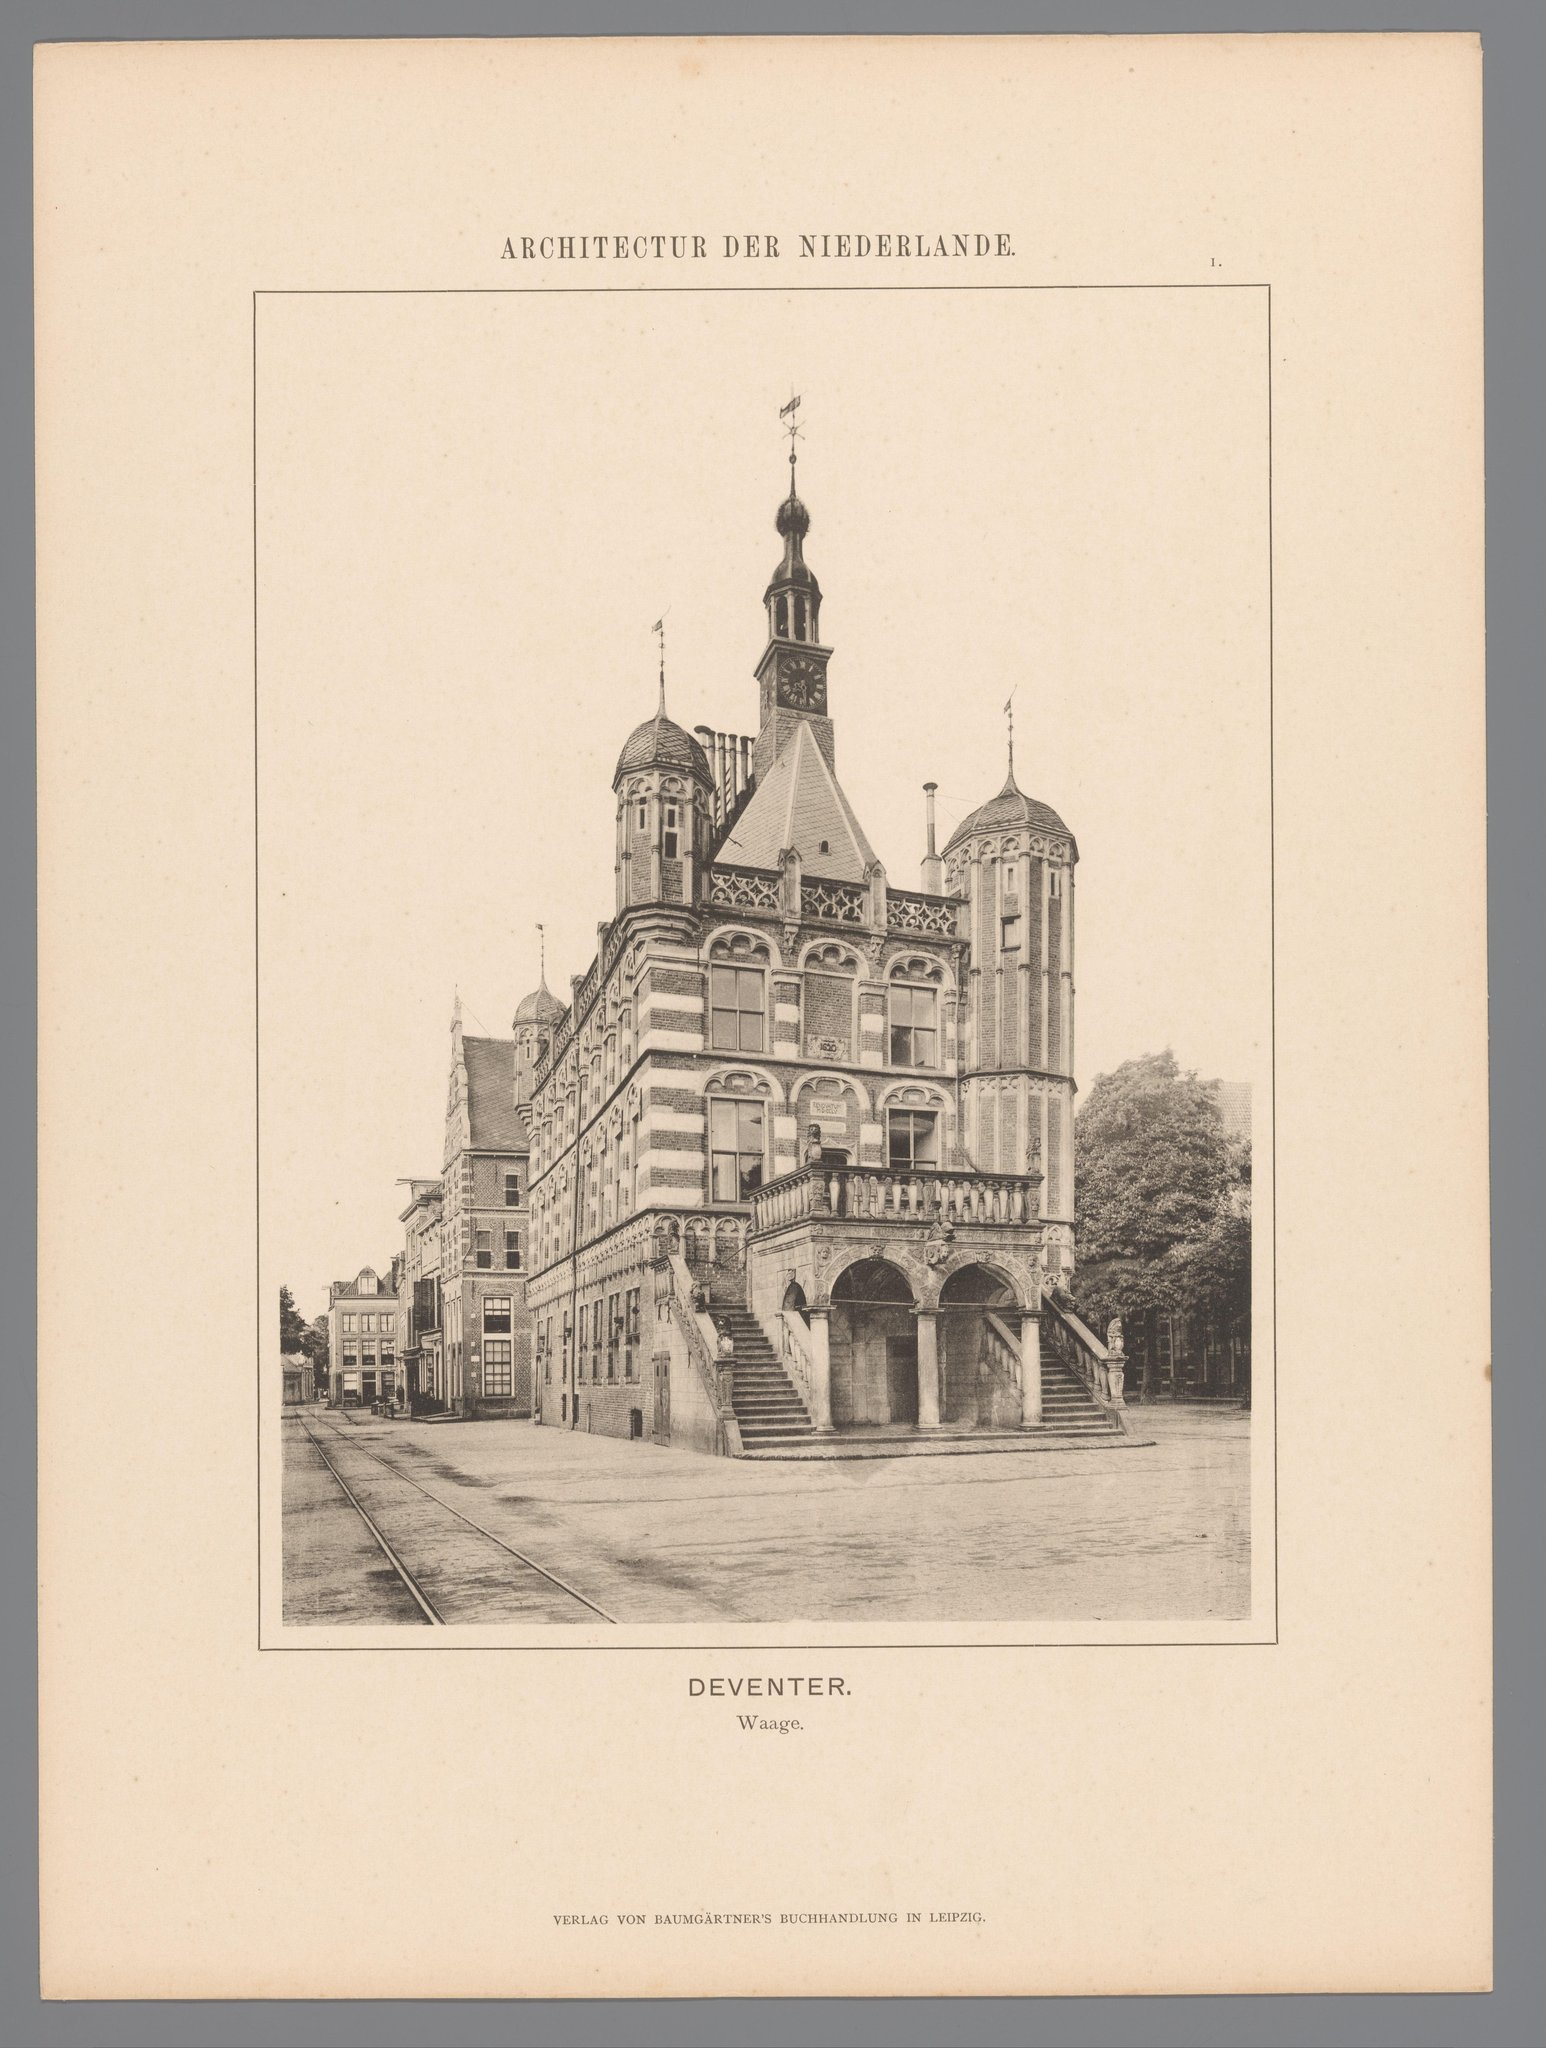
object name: photomechanical print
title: Architectuur in Nederland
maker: Anonymous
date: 1894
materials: paper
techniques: photograph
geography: leipzig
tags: weigh-house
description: Afdruk uit: Krook, L. Architectur der Niederlande. Leipzig: Baumgärtner's Buchhandlung, 1894.